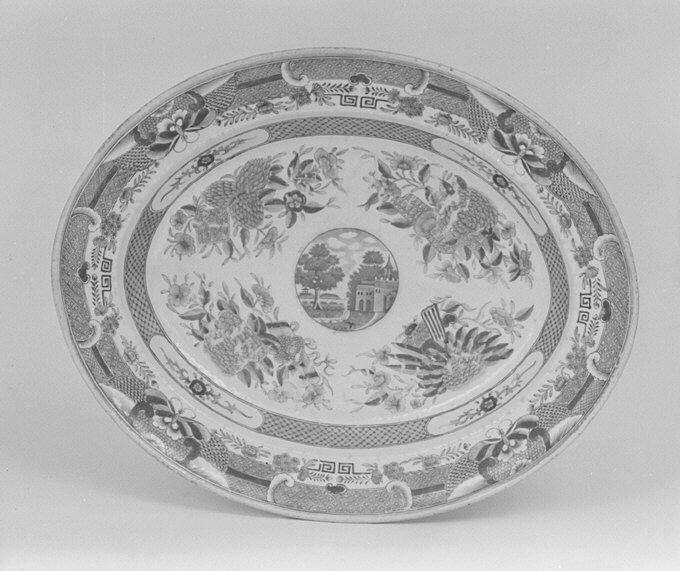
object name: platter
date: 1801-1833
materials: hard paste porcelain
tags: houses,flowers,trees